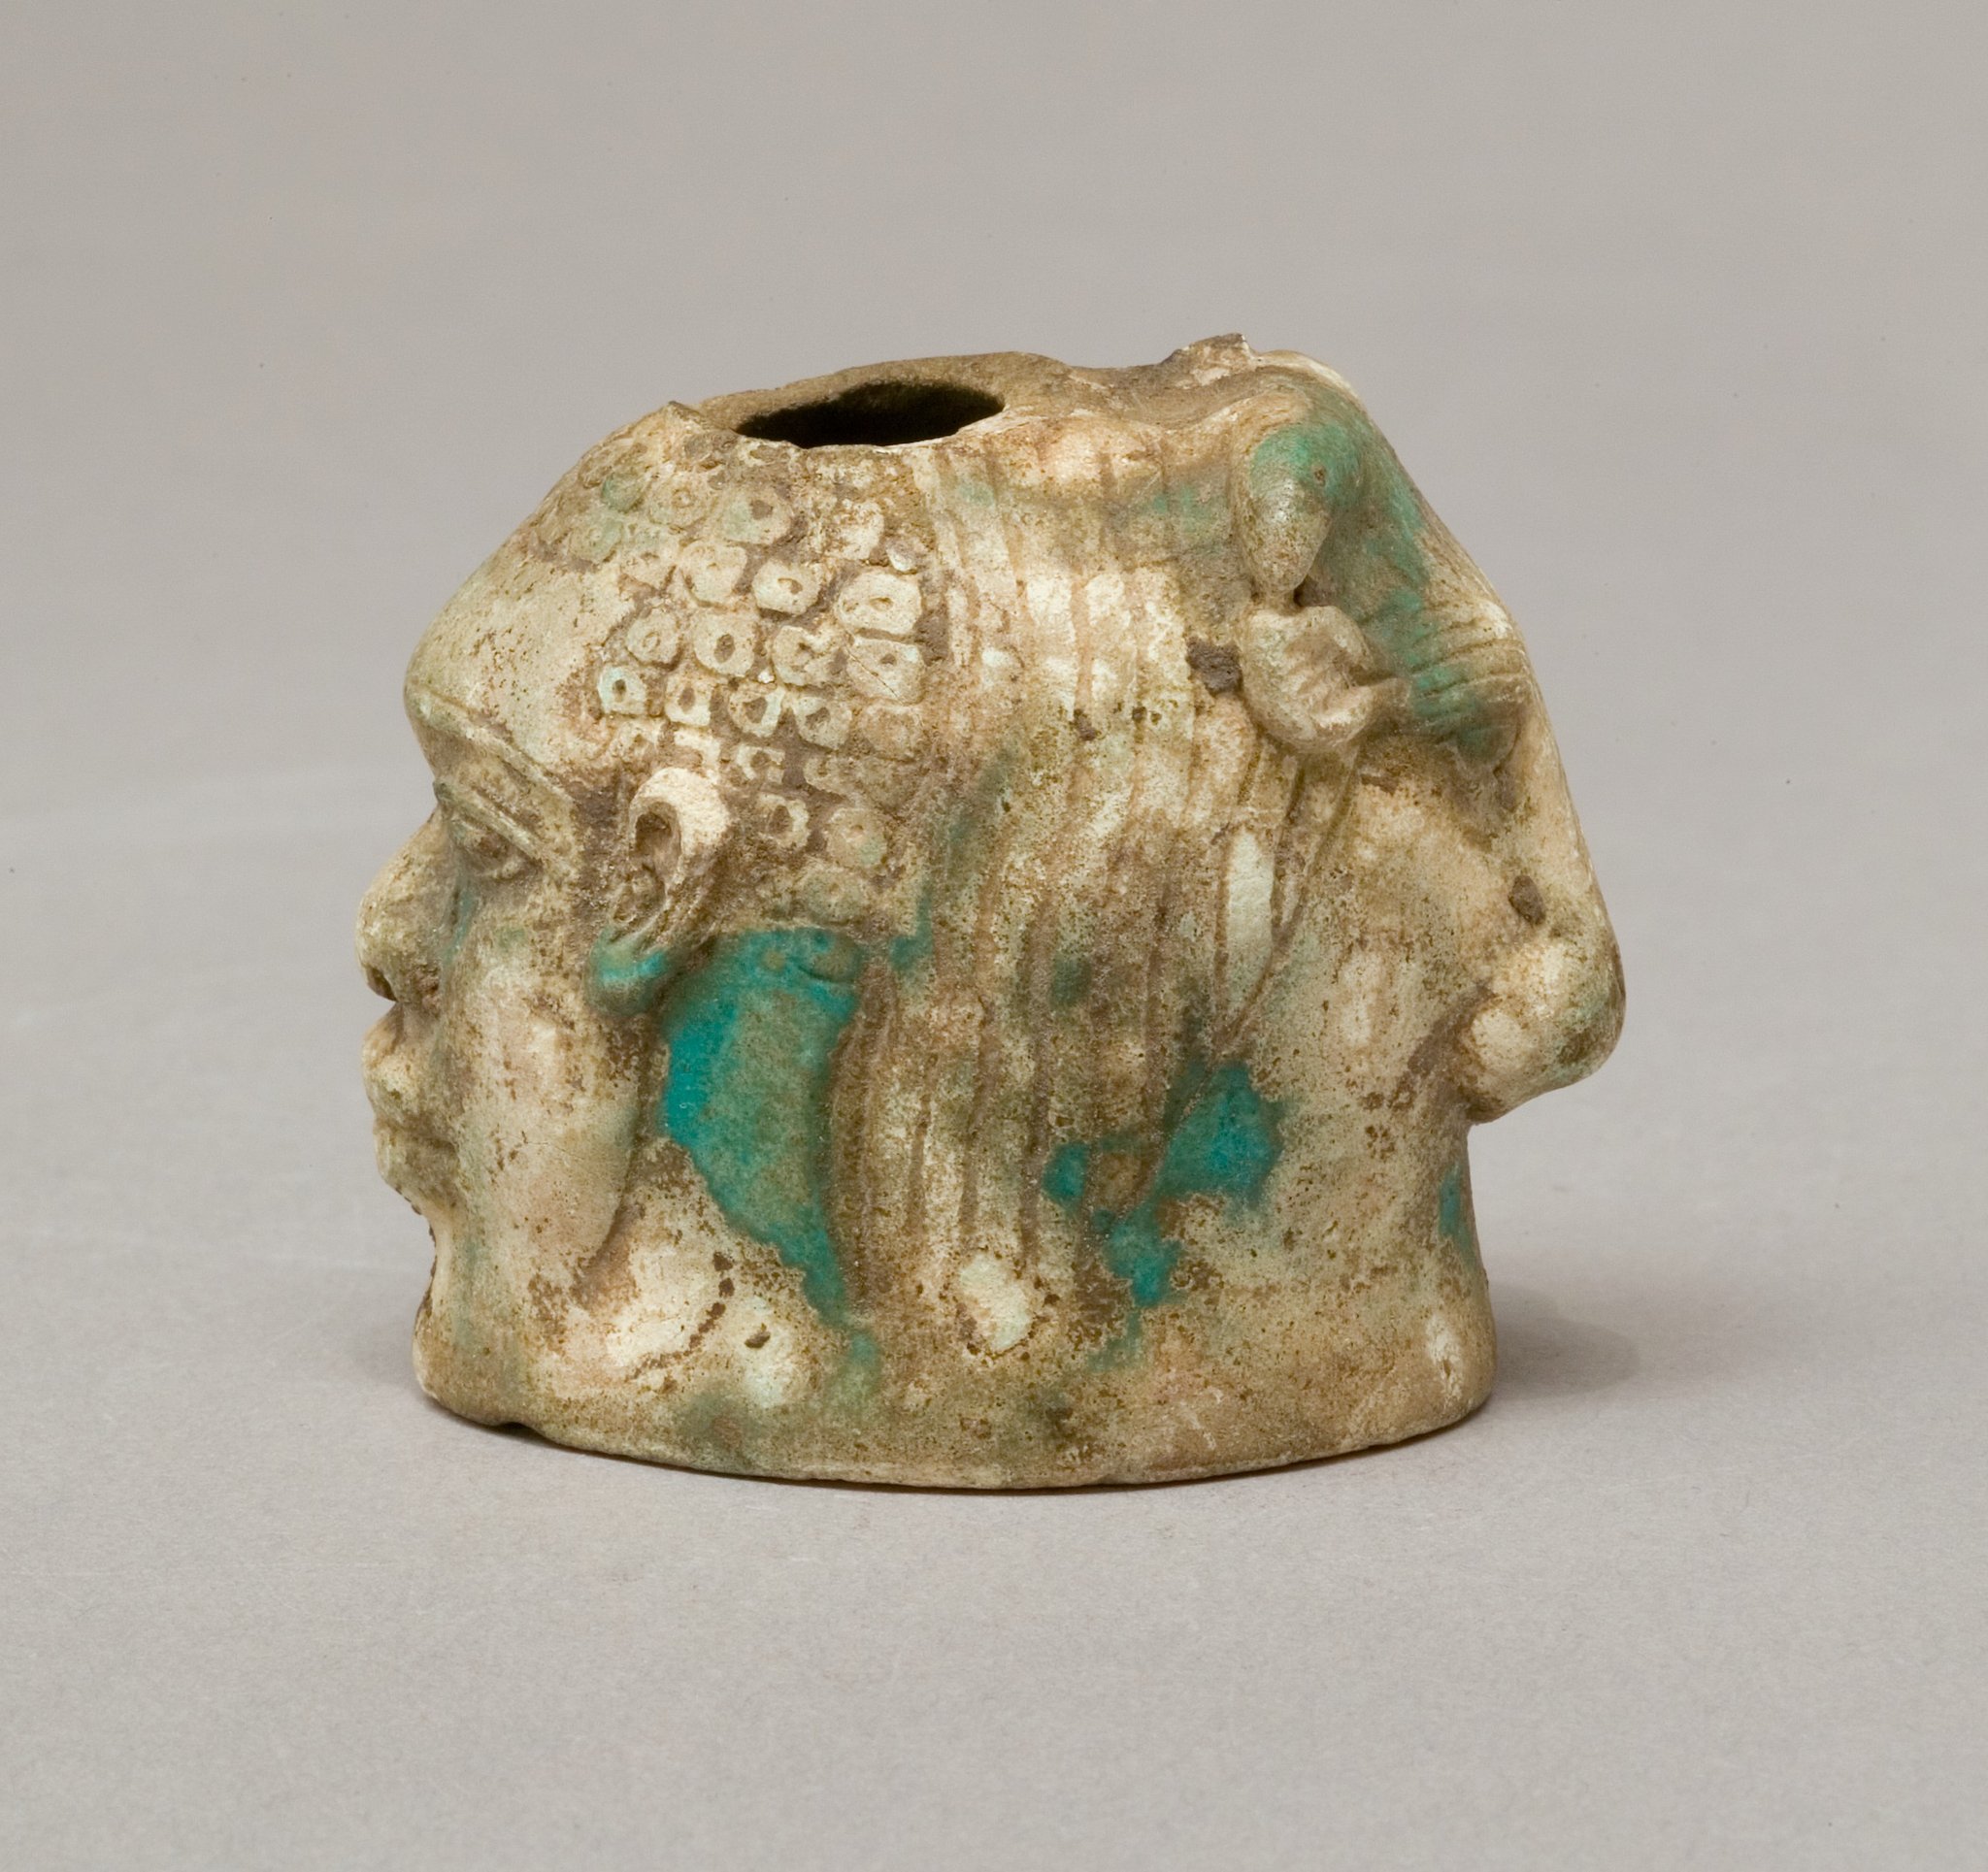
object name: vase, aryballos, janus faced with nubian and bull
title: Janus-faced aryballos depicting a Nubian and a bull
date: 600-550 BCE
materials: faience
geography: egypt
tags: faces,bulls